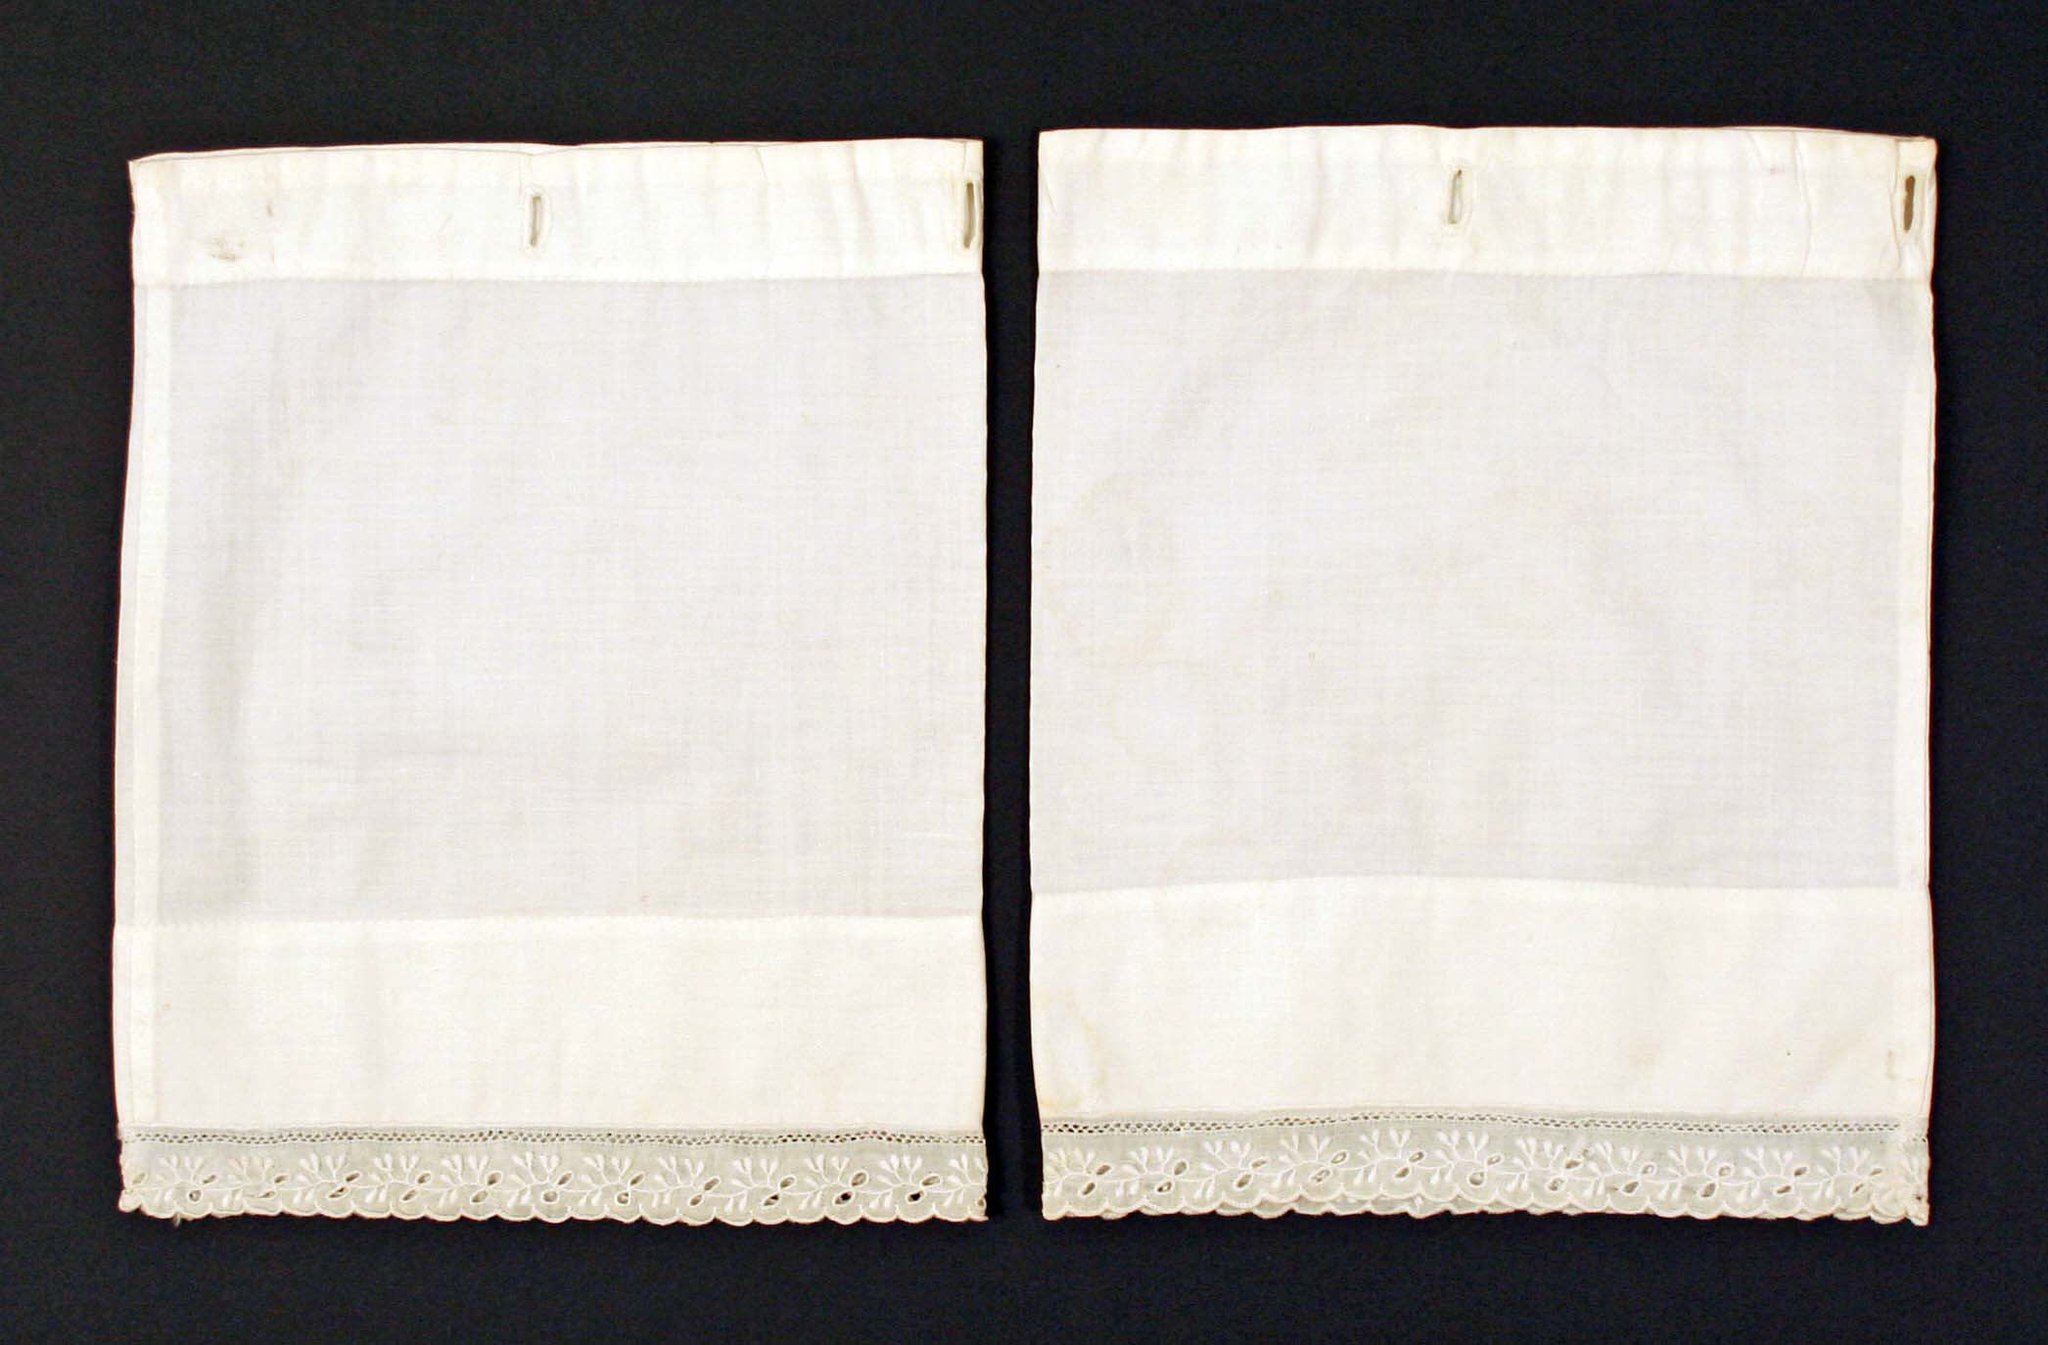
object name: pantalets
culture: american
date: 1838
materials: cotton